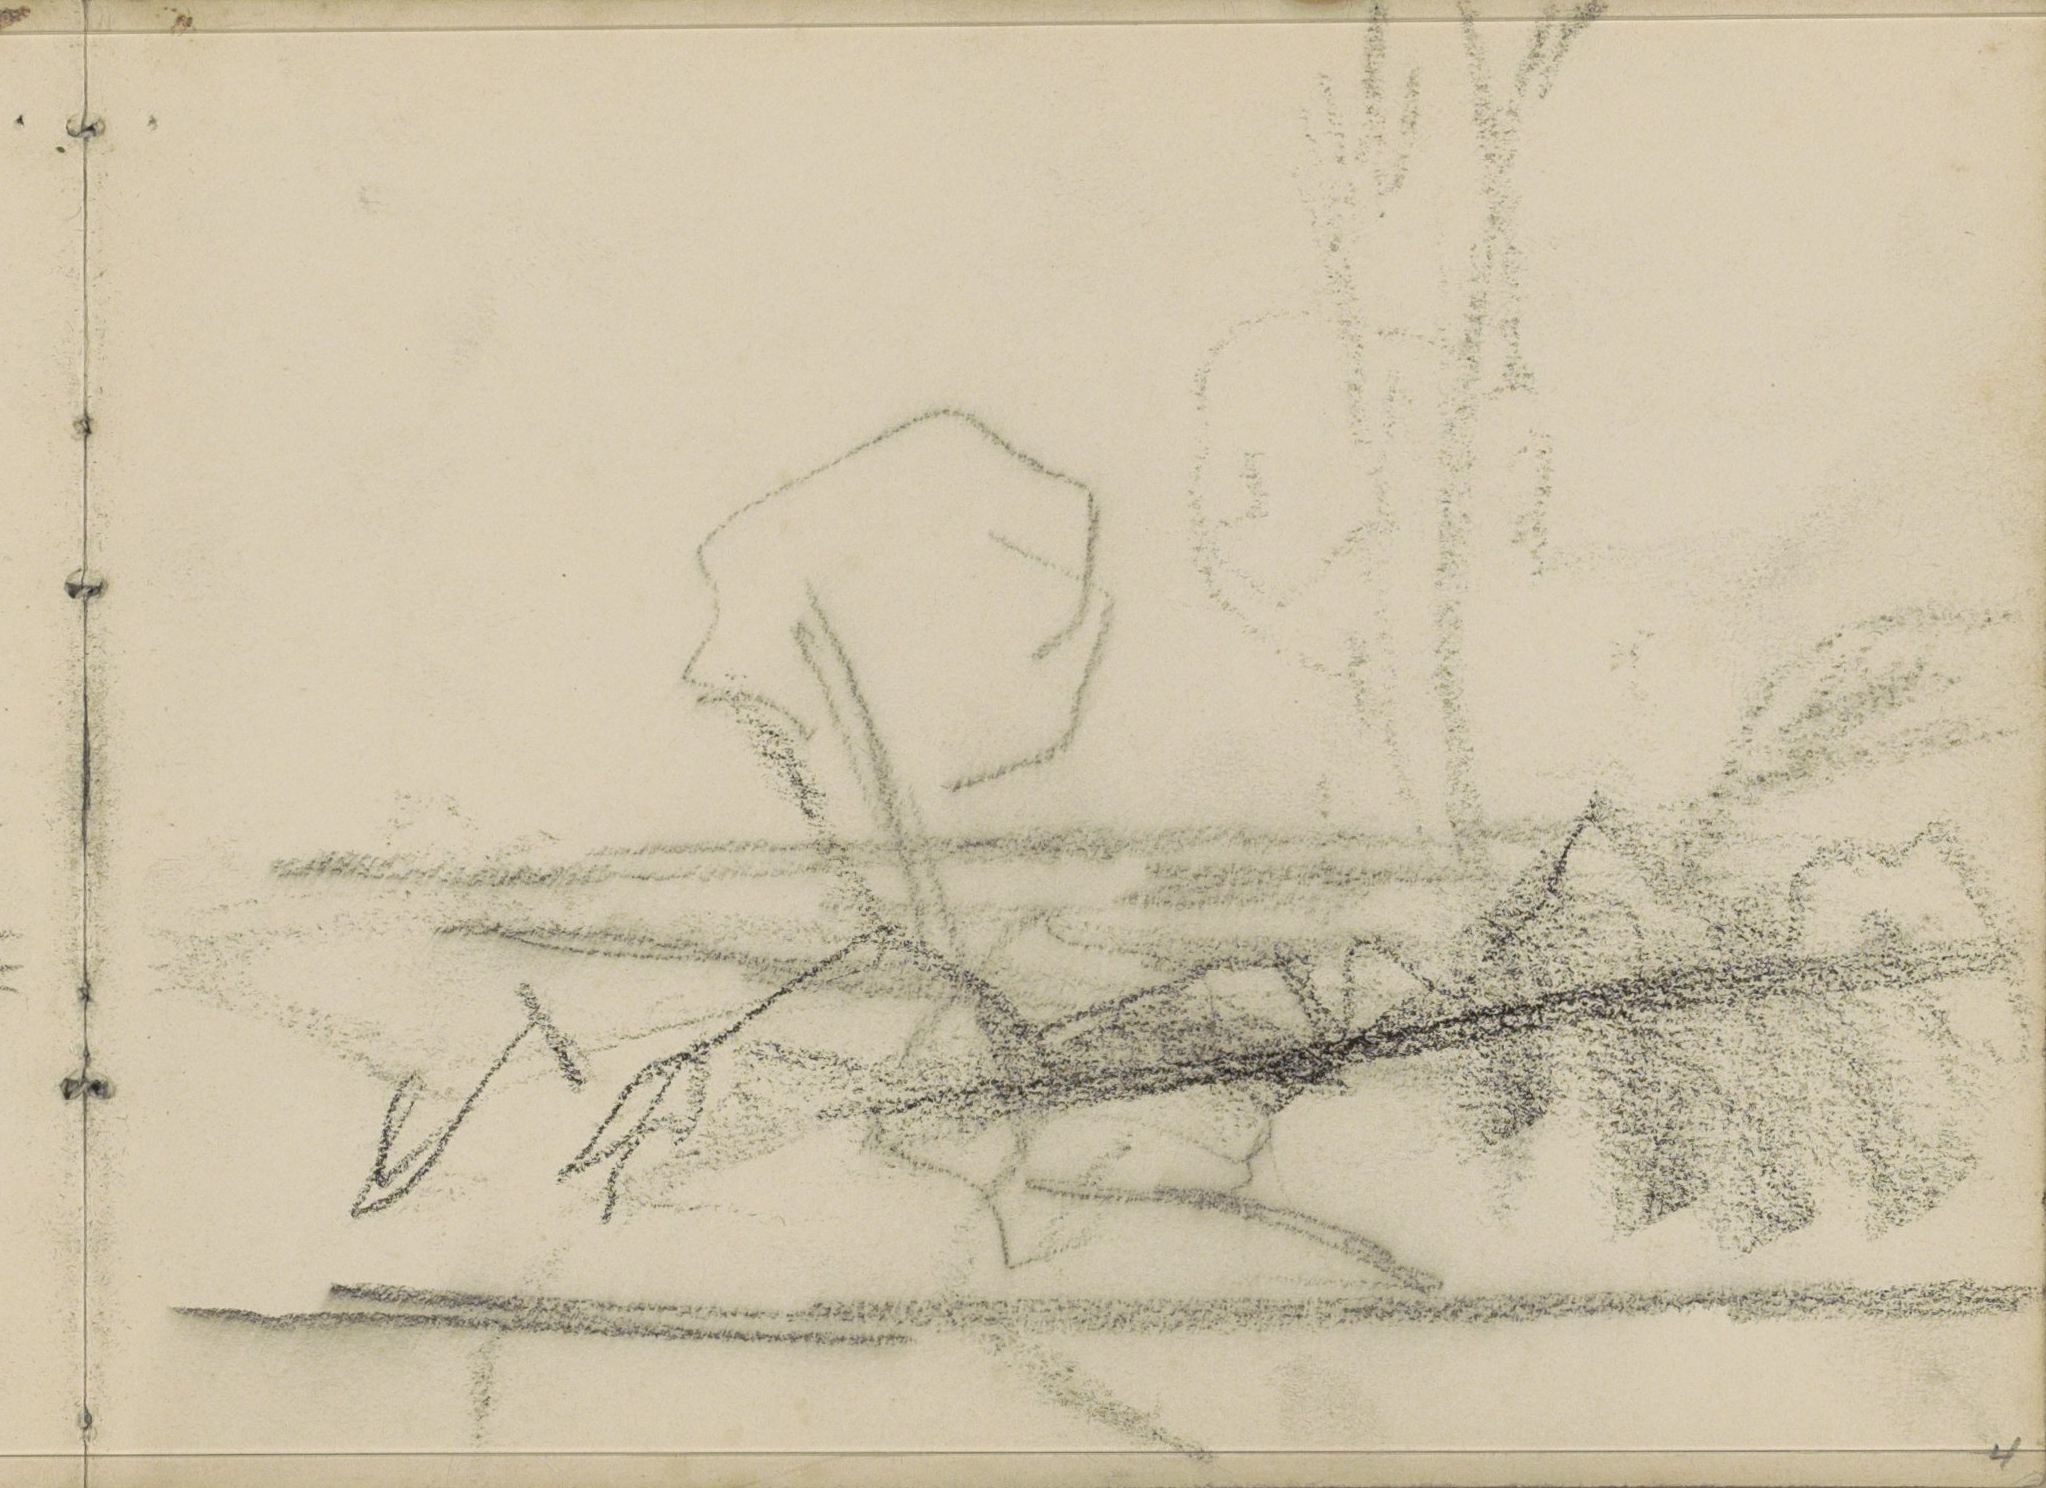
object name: sketchbook leaf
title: Landschap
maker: hermannus adrianus van oosterzee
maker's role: draughtsman, painter, print maker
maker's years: 1863-1933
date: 1893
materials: chalk, paper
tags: landscapes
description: Blad 4 recto uit een schetsboek met 23 bladen.